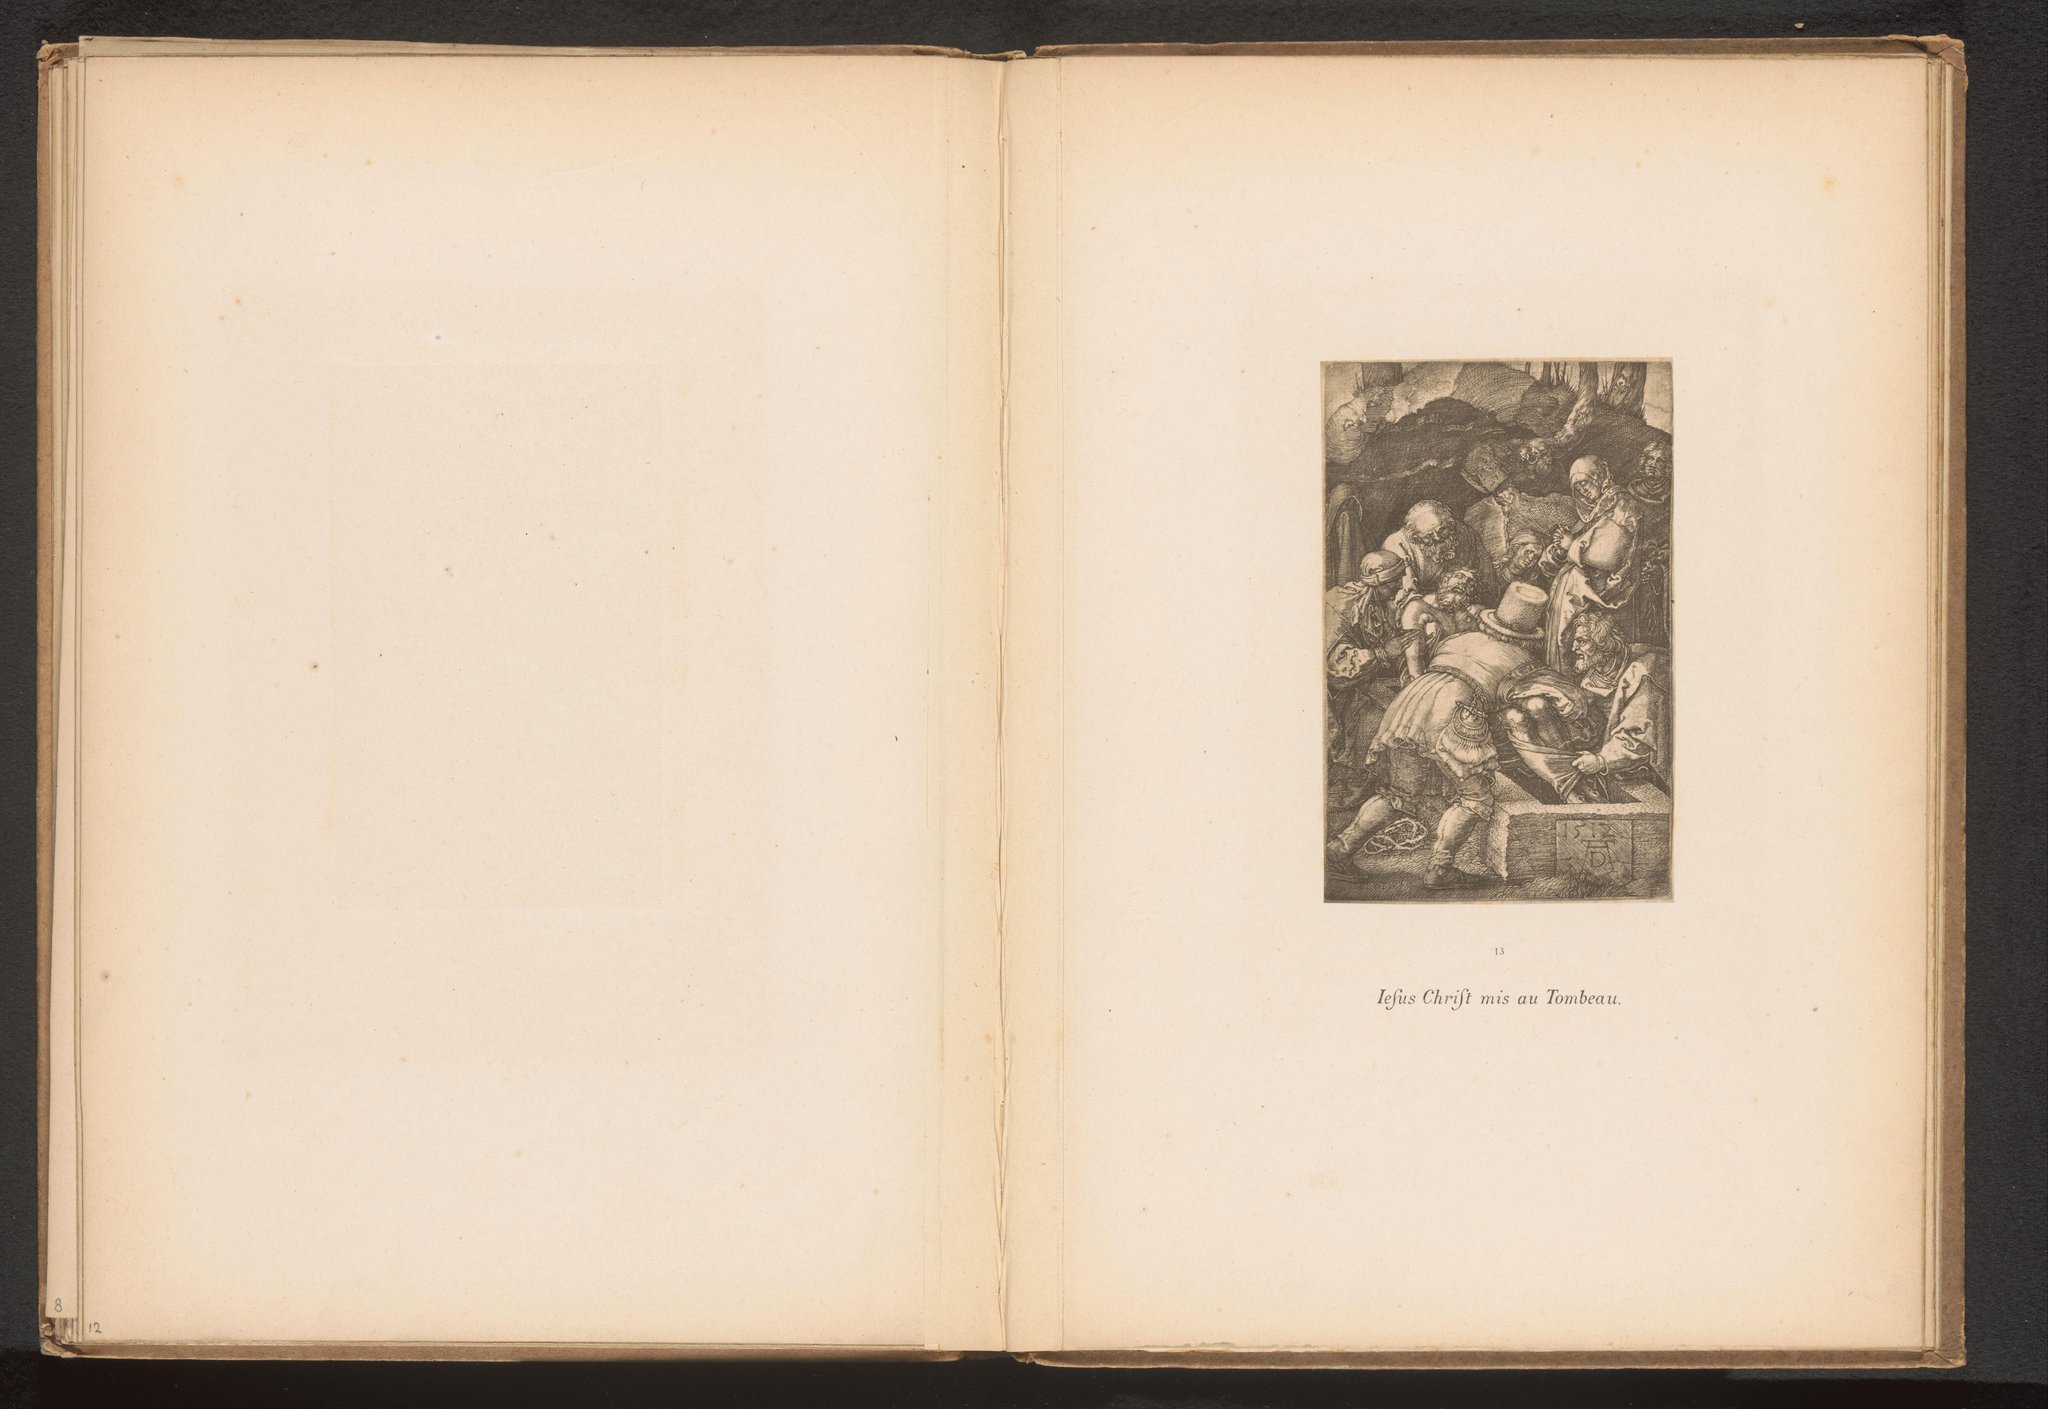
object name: reproduction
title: Reproductie van De graflegging door Albrecht Dürer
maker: albrecht dürer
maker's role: draughtsman, painter, print maker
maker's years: 1471-1528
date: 1866-1871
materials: paper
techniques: woodburytype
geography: brussels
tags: christ's entombment (possibly by angels), passion of christ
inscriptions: number: ‘13’